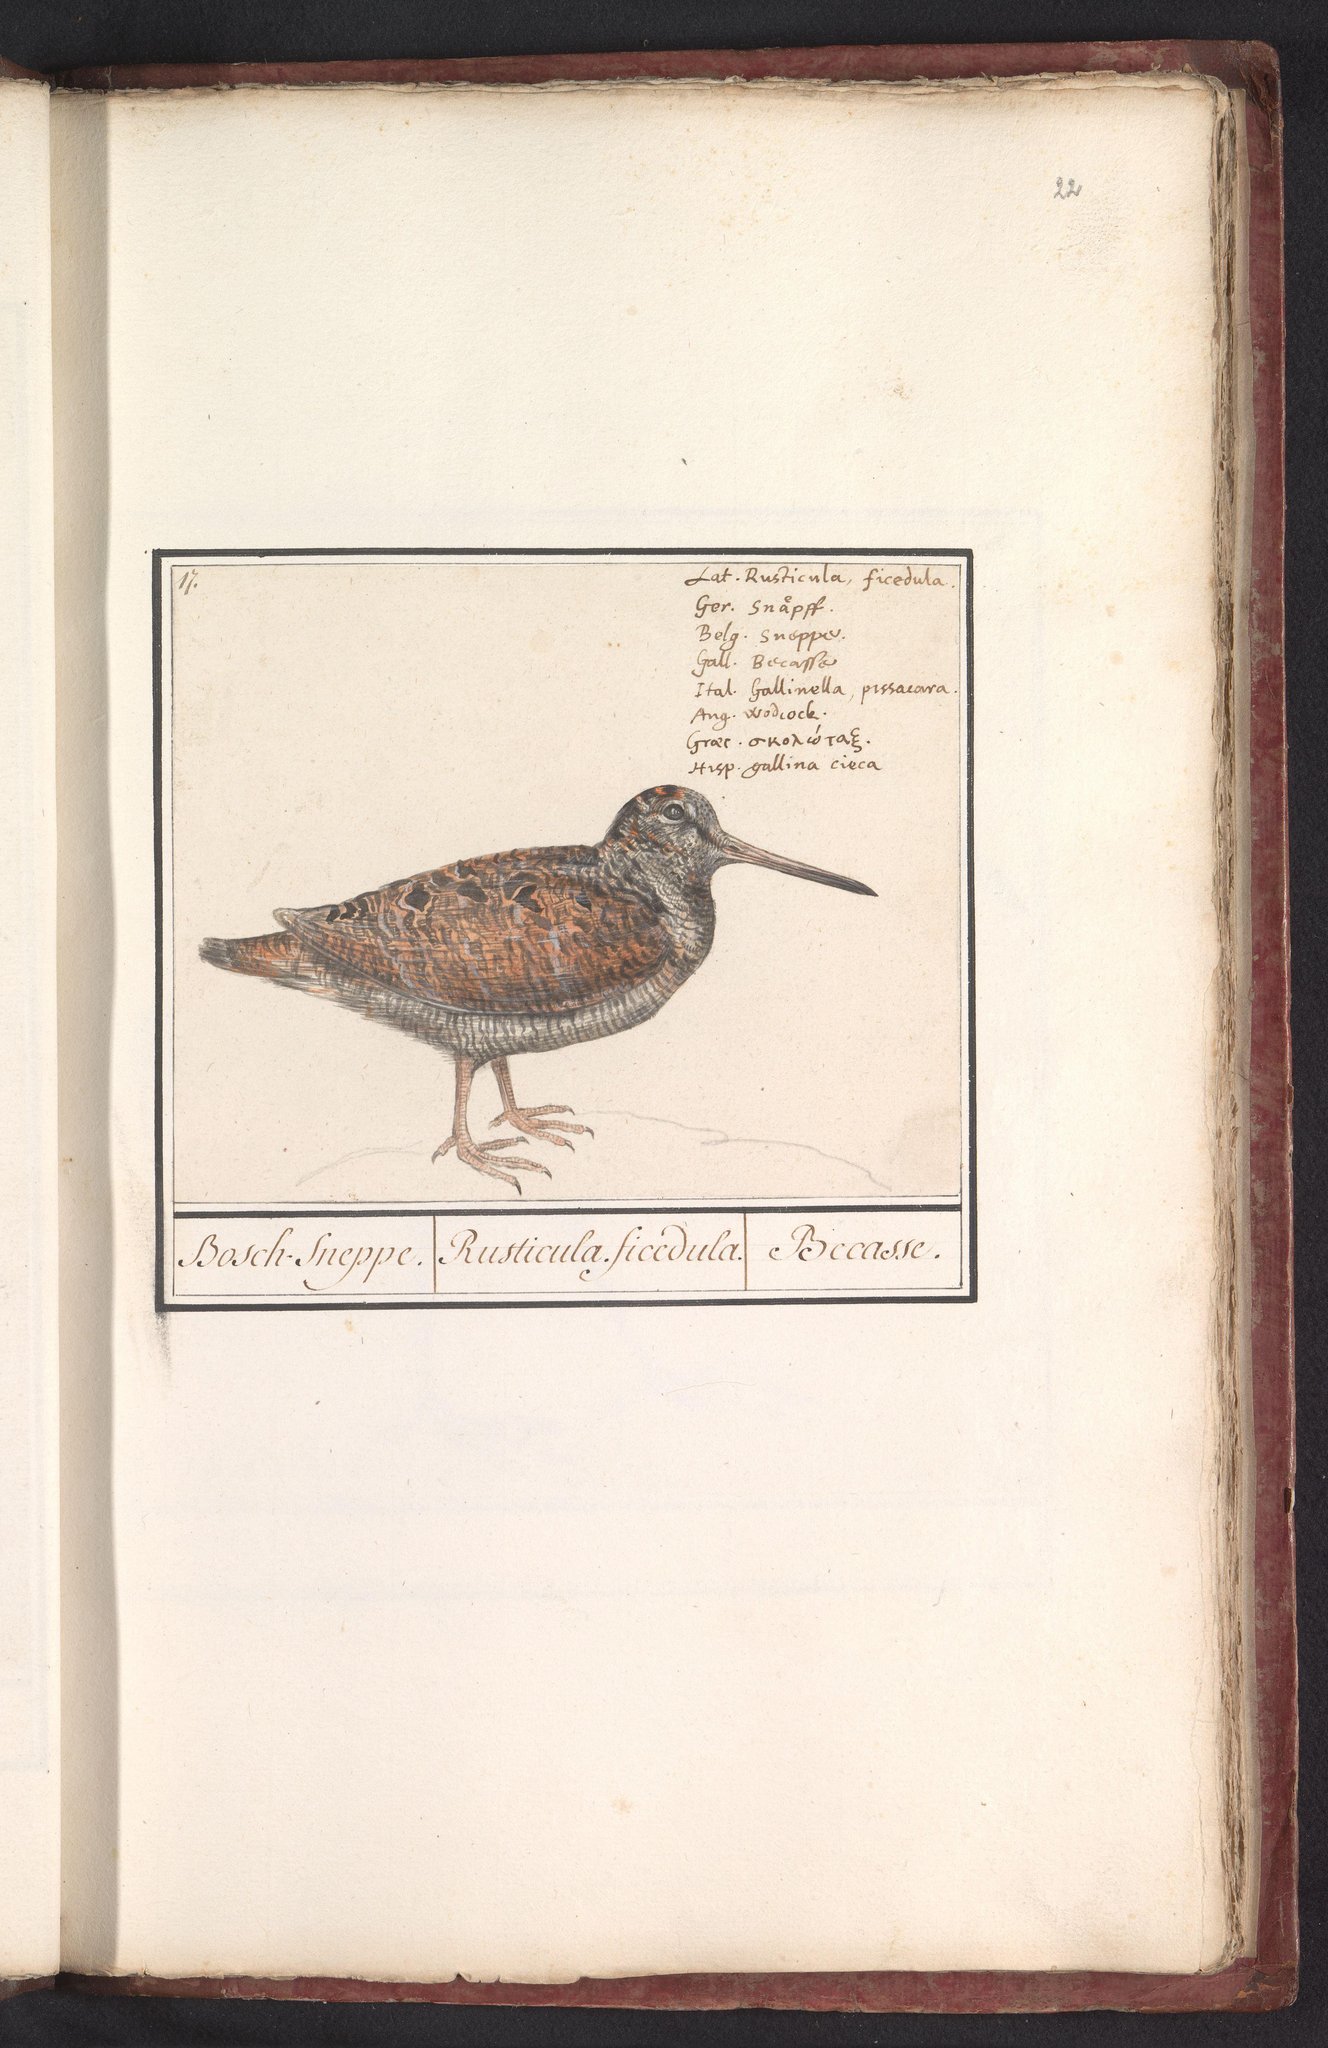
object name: drawing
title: Eurasian Woodcock (Scolopax rusticola)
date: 1596-1610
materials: chalk, paint, ink, paper, pencil, watercolor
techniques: brush, pen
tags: shore-birds and wading-birds: woodcock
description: In Rudolf II’s menagerie (zoo) in Prague, De Boodt could study living animals from distant places, and in the emperor’s Kunstkammer (Cabinet of Curiosities) he could find stuffed specimens. Yet he also drew some creatures after existing images. For this woodcock, the draughtsman probably did not need to consult such sources: the bird was common in and around Prague.